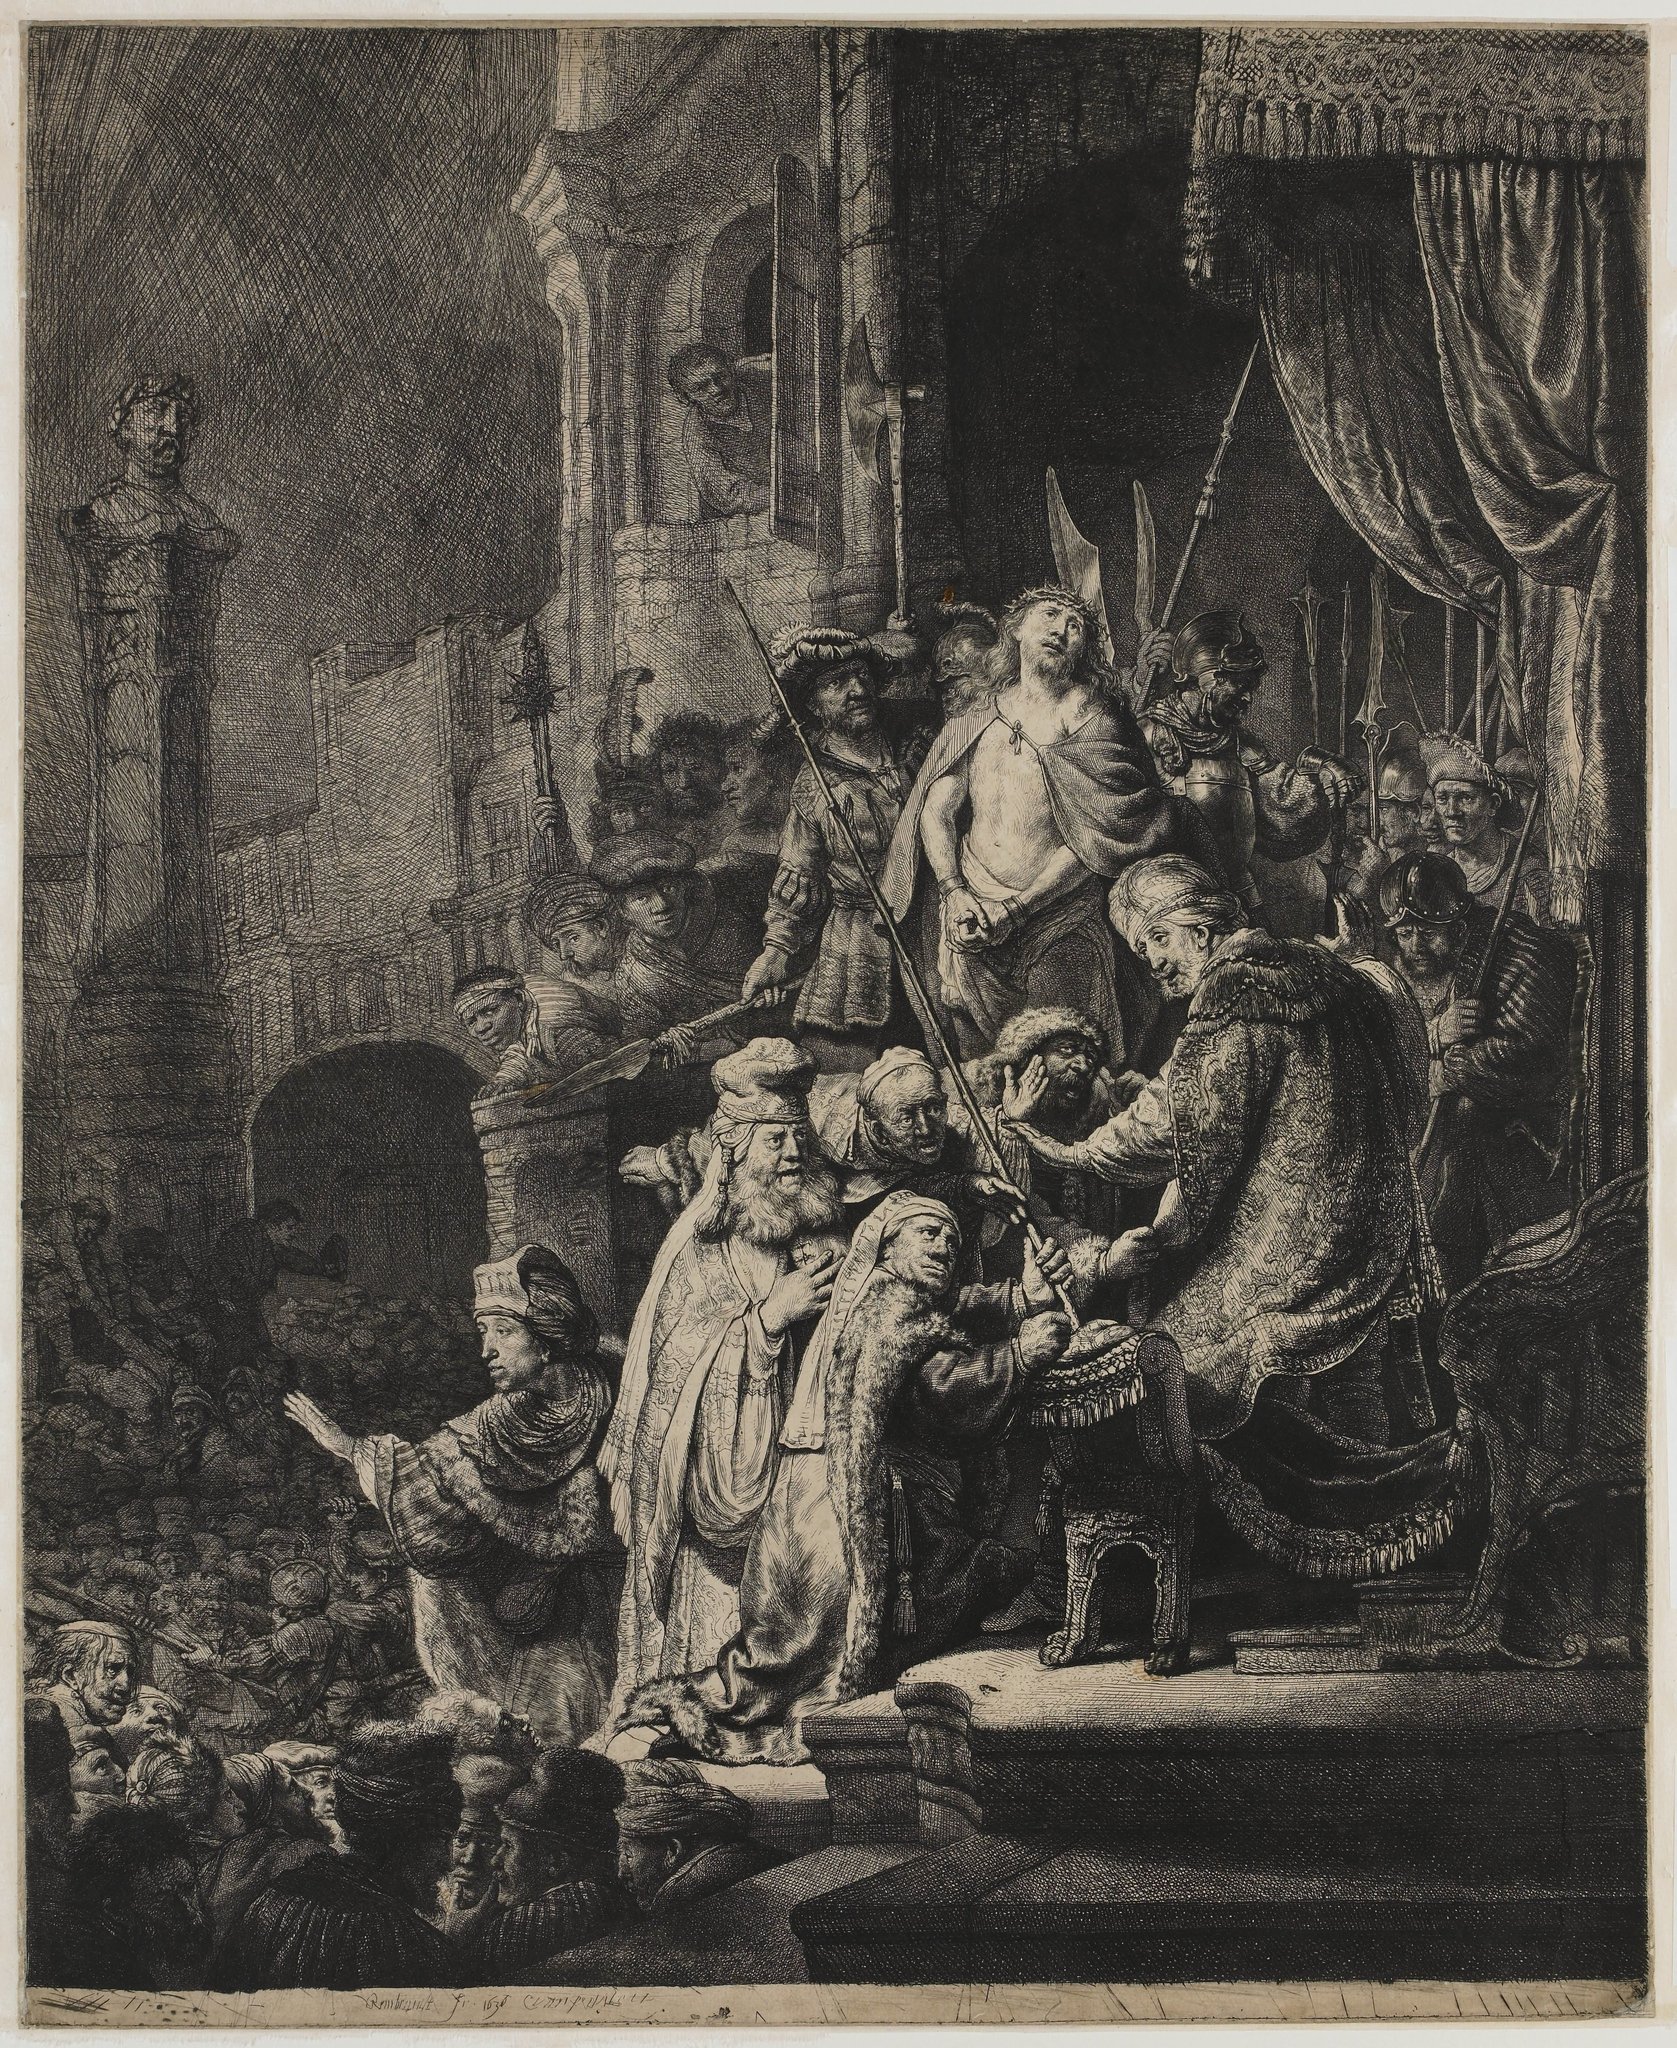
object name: print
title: Christ before Pilate: large plate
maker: rembrandt van rijn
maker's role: draughtsman, painter, print maker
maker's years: 1606-1669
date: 1635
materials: paper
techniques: etching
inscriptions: inscription: ‘First variation of the fist state (...) holds the reed’, inscription: ‘P. 1 (in een cirkel) 98’, signature and date: ‘Rembrandt f 1636 cvm privilege’, mark: Lugt 1880, inscription: ‘4 - 5 -’